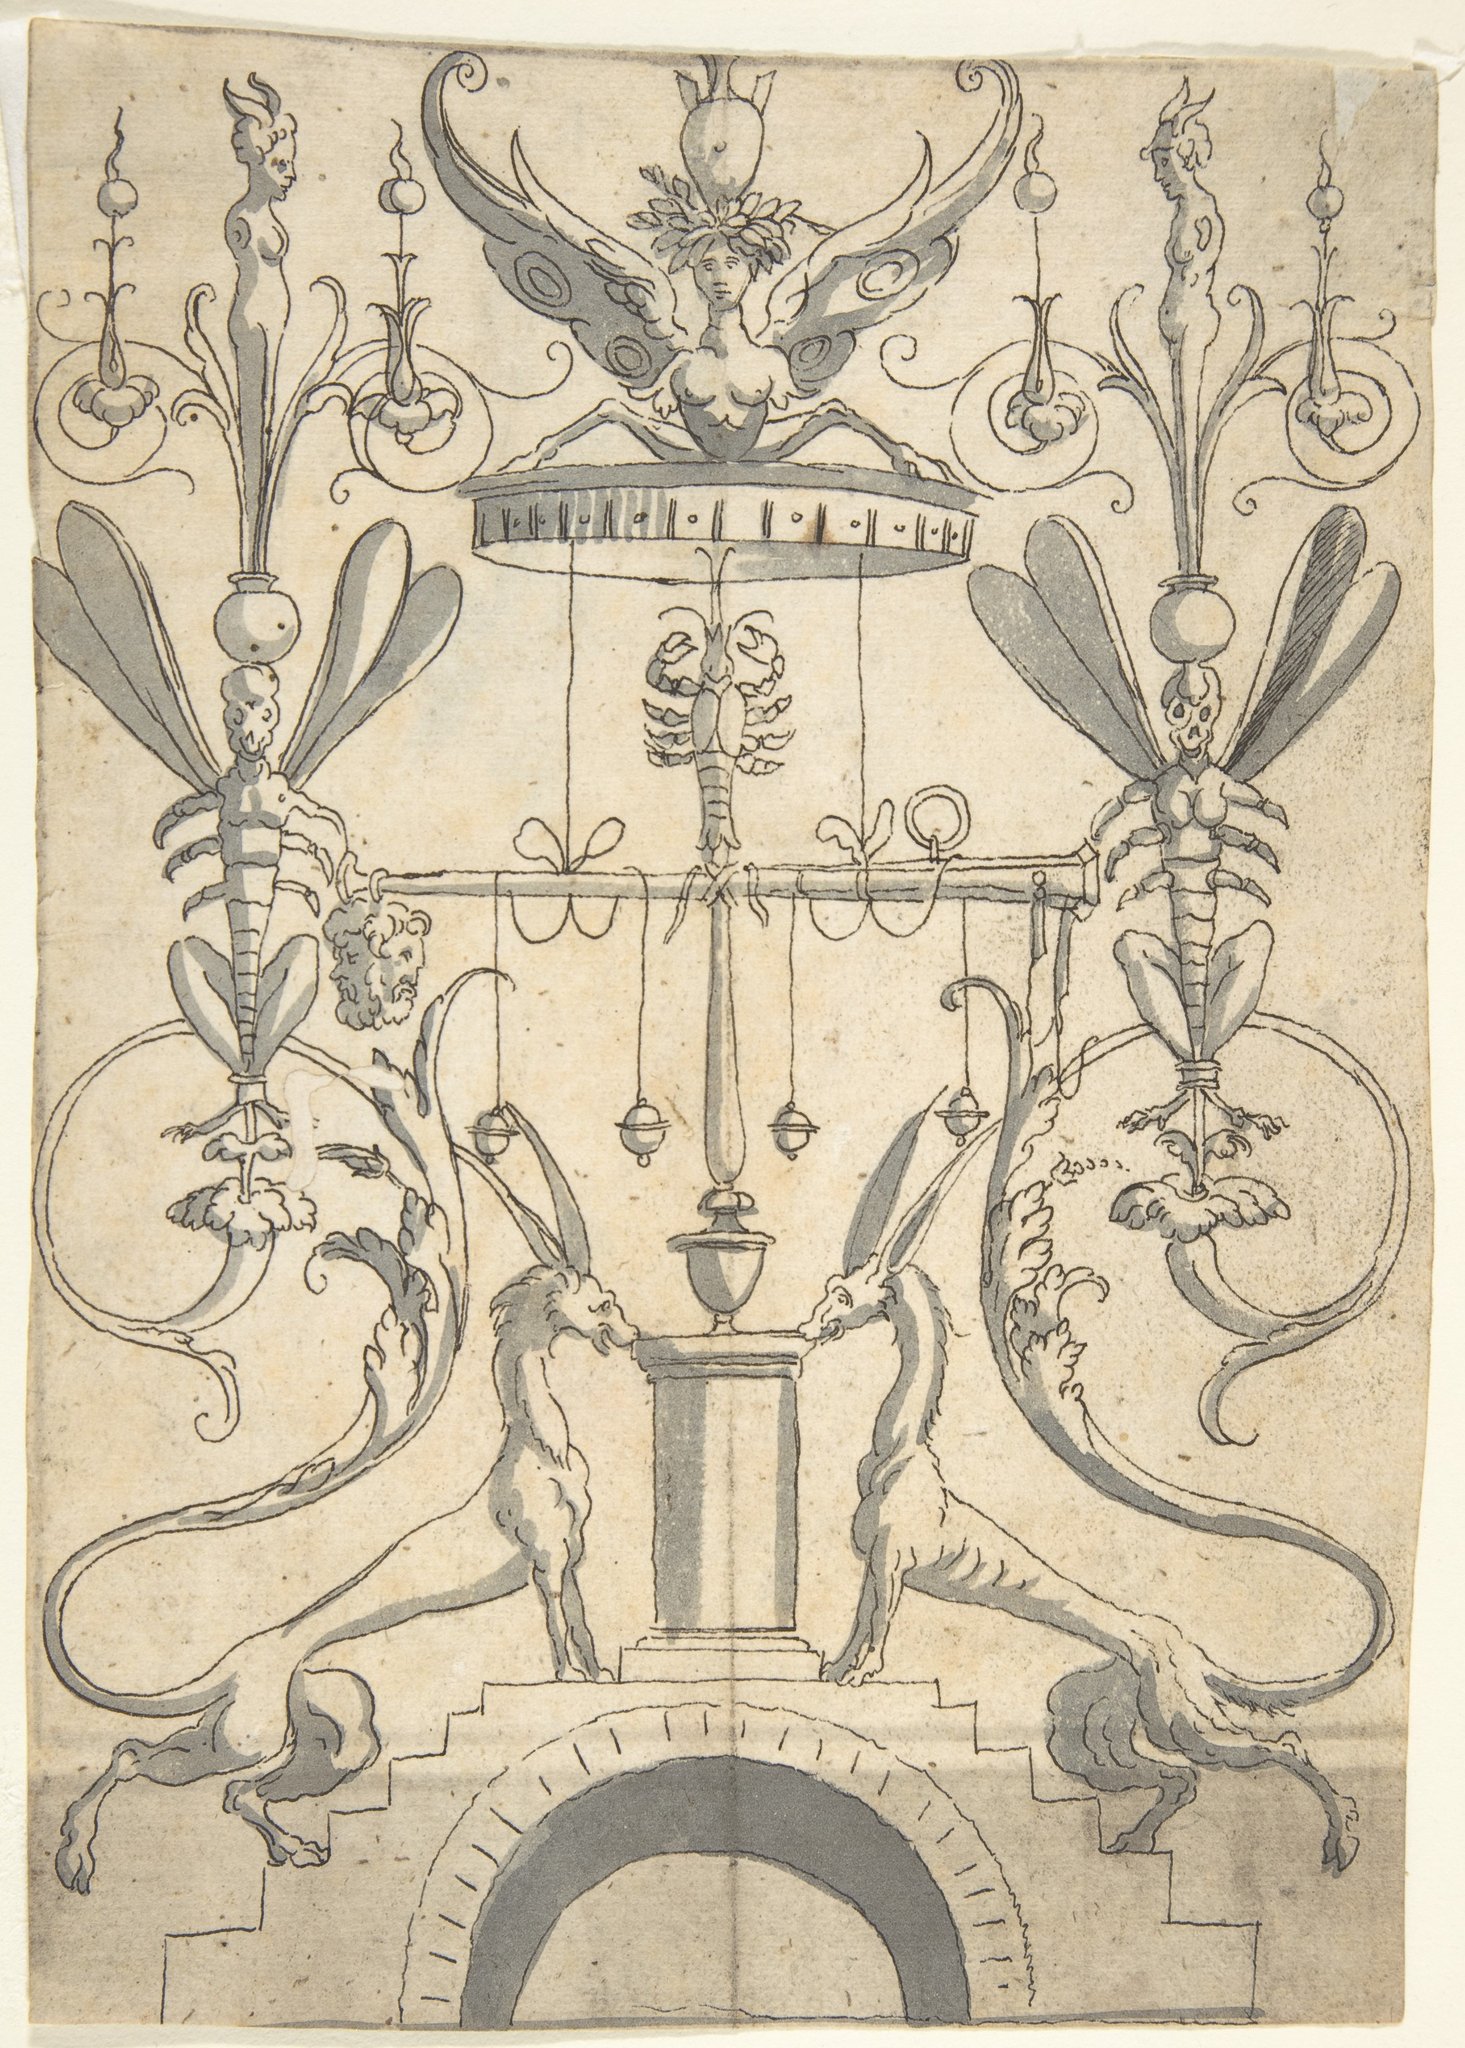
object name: ornament architecture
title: Candelabra Grotesque on a Pedestal with Fantastical Creatures and a Lobster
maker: anonymous, italian, 16th century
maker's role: artist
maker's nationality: italian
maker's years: 1500-1600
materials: ink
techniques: brush, pen, wash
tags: lobsters,candelabra